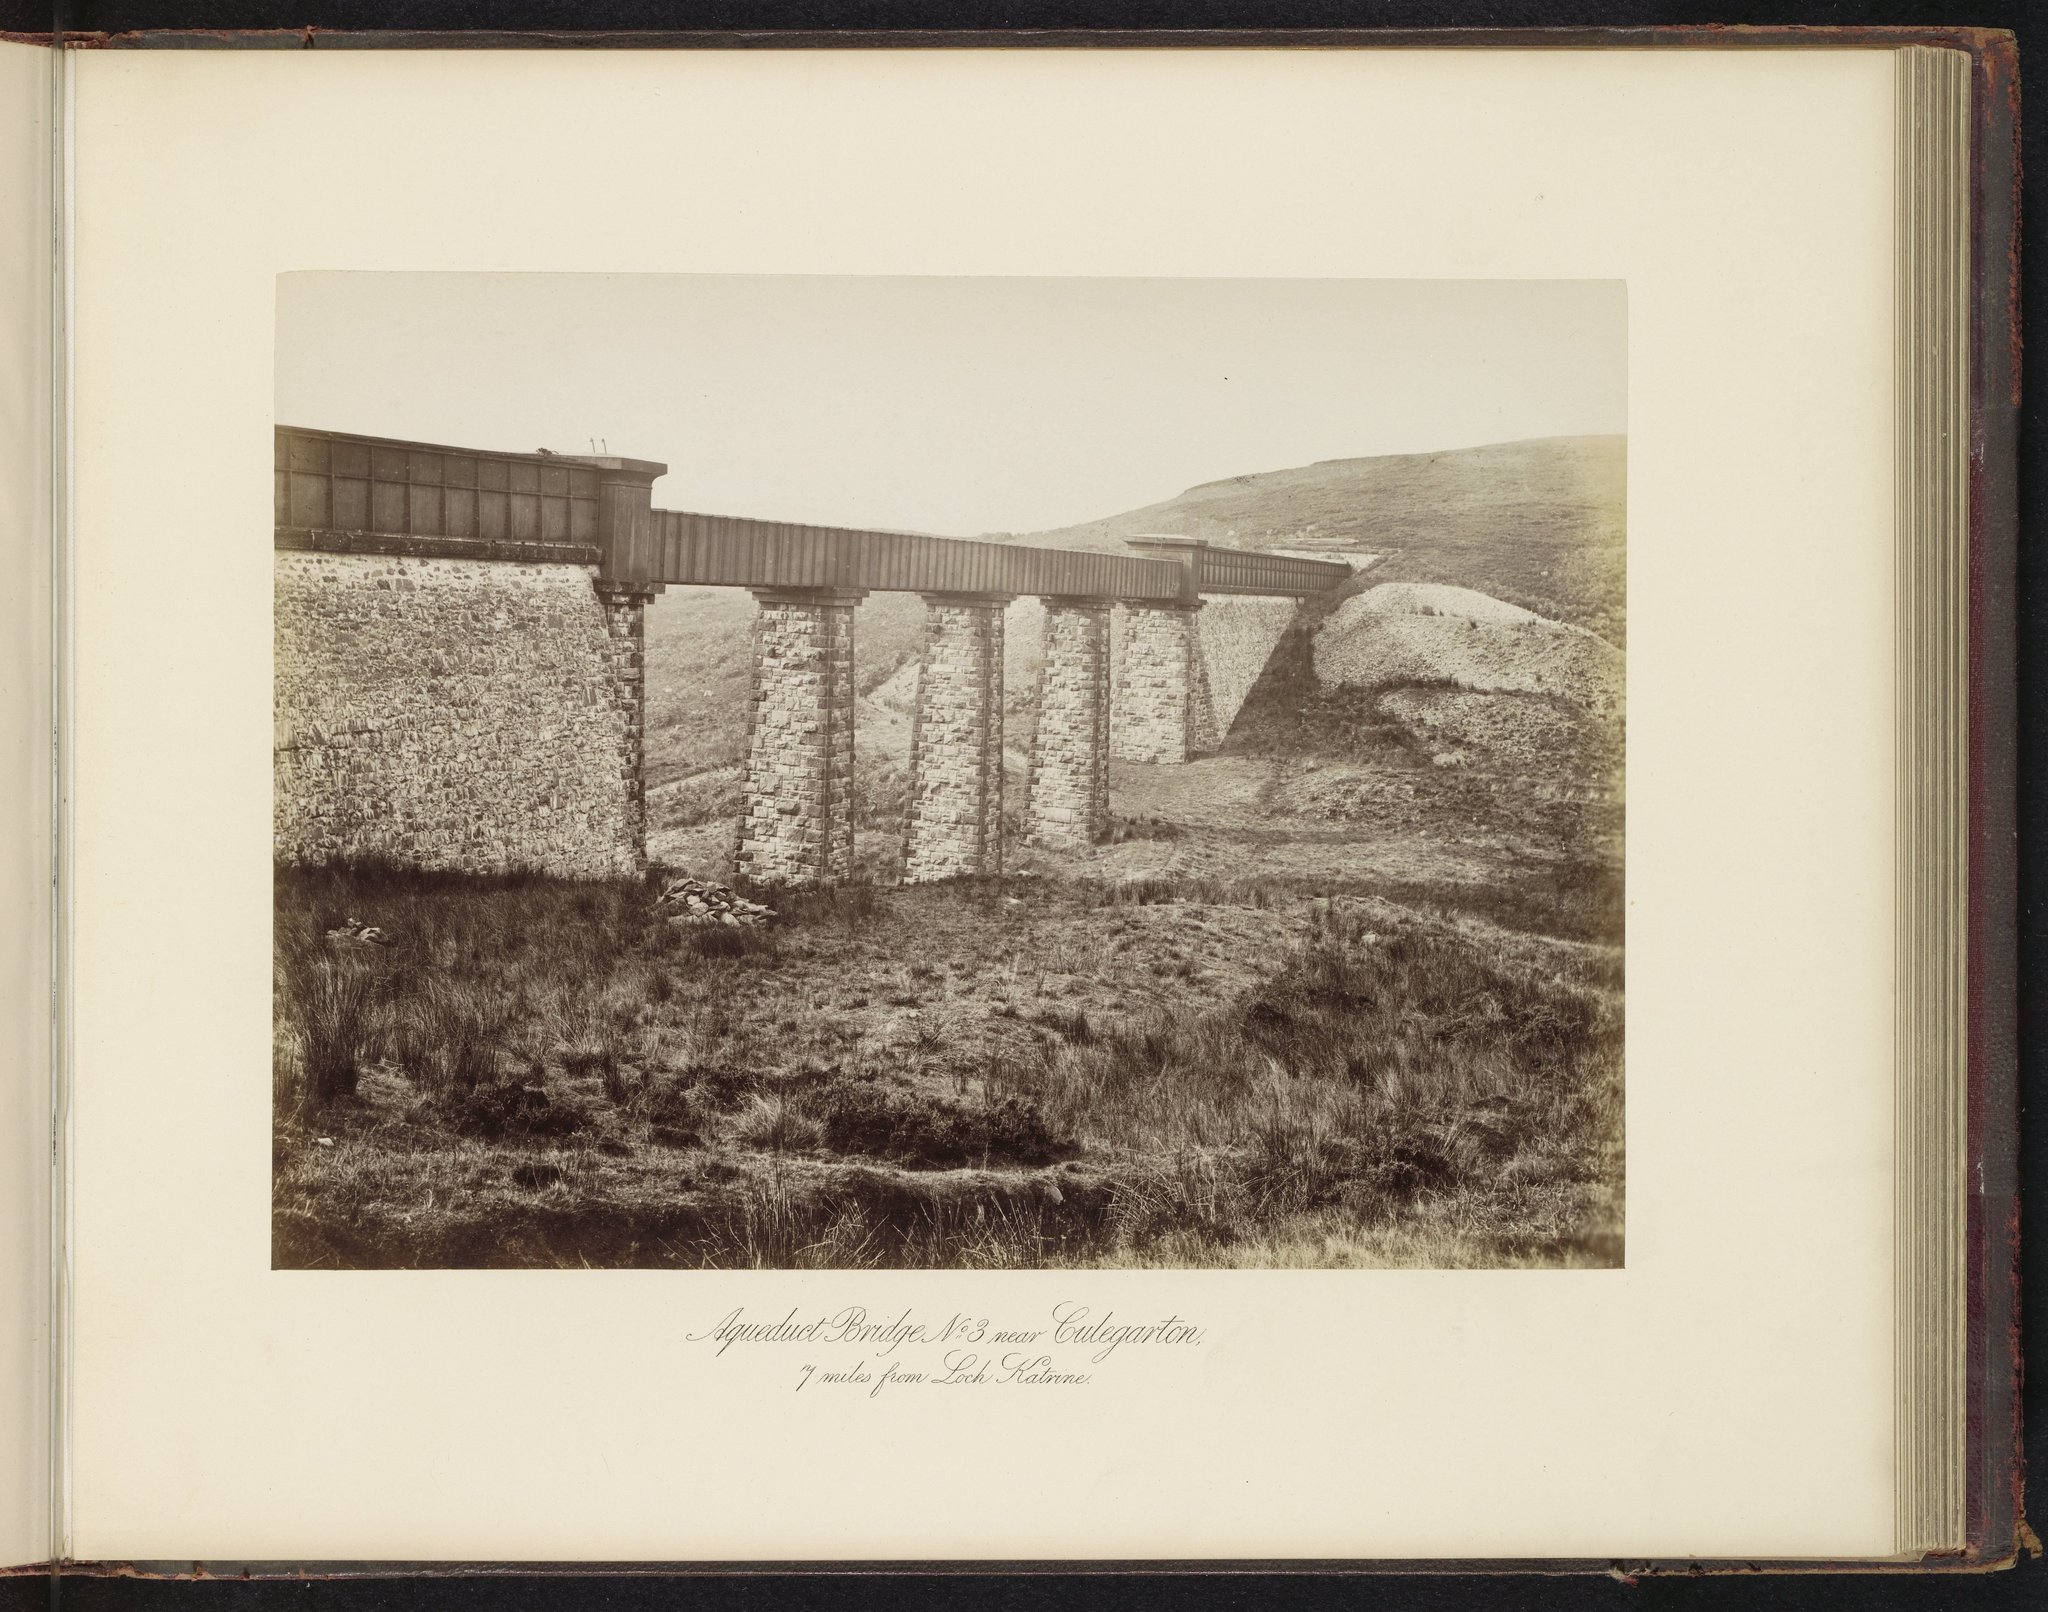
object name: page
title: Aqueduct bridge, No 3 near Culegarten, 7 miles from Loch Katrine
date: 1879-1889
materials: photographic support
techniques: albumen print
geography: stirling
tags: dale, valley, aqueduct (~ water supply)